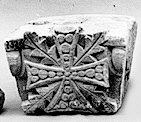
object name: keystone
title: Keystone from an Arch with Cross and Acanthus Leaves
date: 301-500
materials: limestone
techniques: carving, relief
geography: egypt